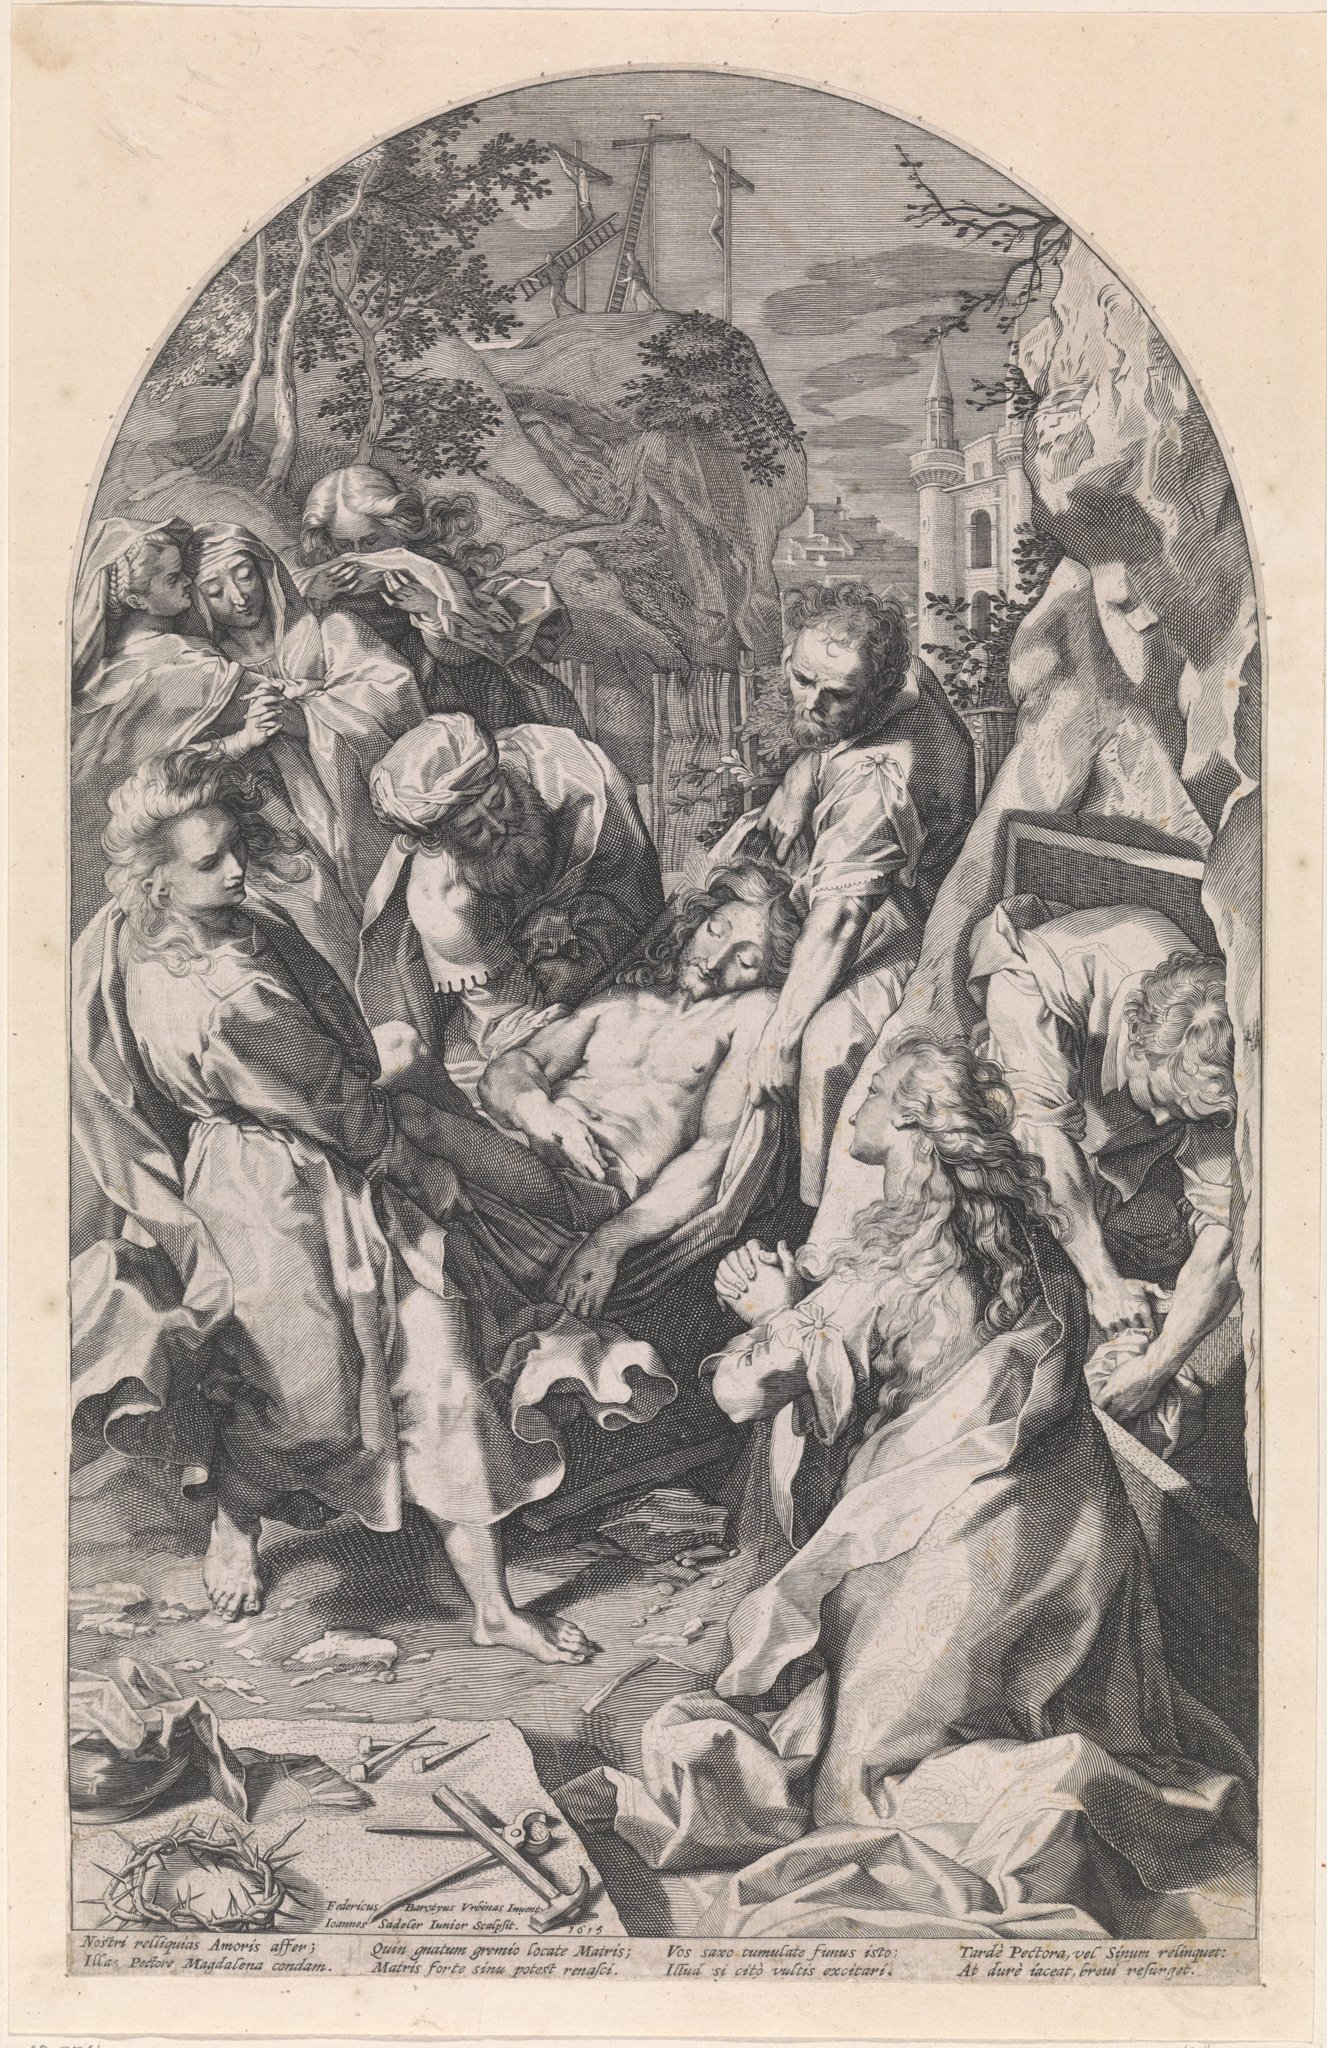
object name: print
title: Graflegging van Christus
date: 1615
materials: paper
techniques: engraving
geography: germany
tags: christ's entombment (possibly by angels)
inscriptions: collector's mark: Lugt 240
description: Christus wordt in een graftombe gelegd. Op de voorgrond rechts zit de geknielde Maria Magdalena. Links liggen enkele passiewerktuigen van Christus (hamer, tang, spijkers, doornenkroon). Op de achtergrond de kruisberg.